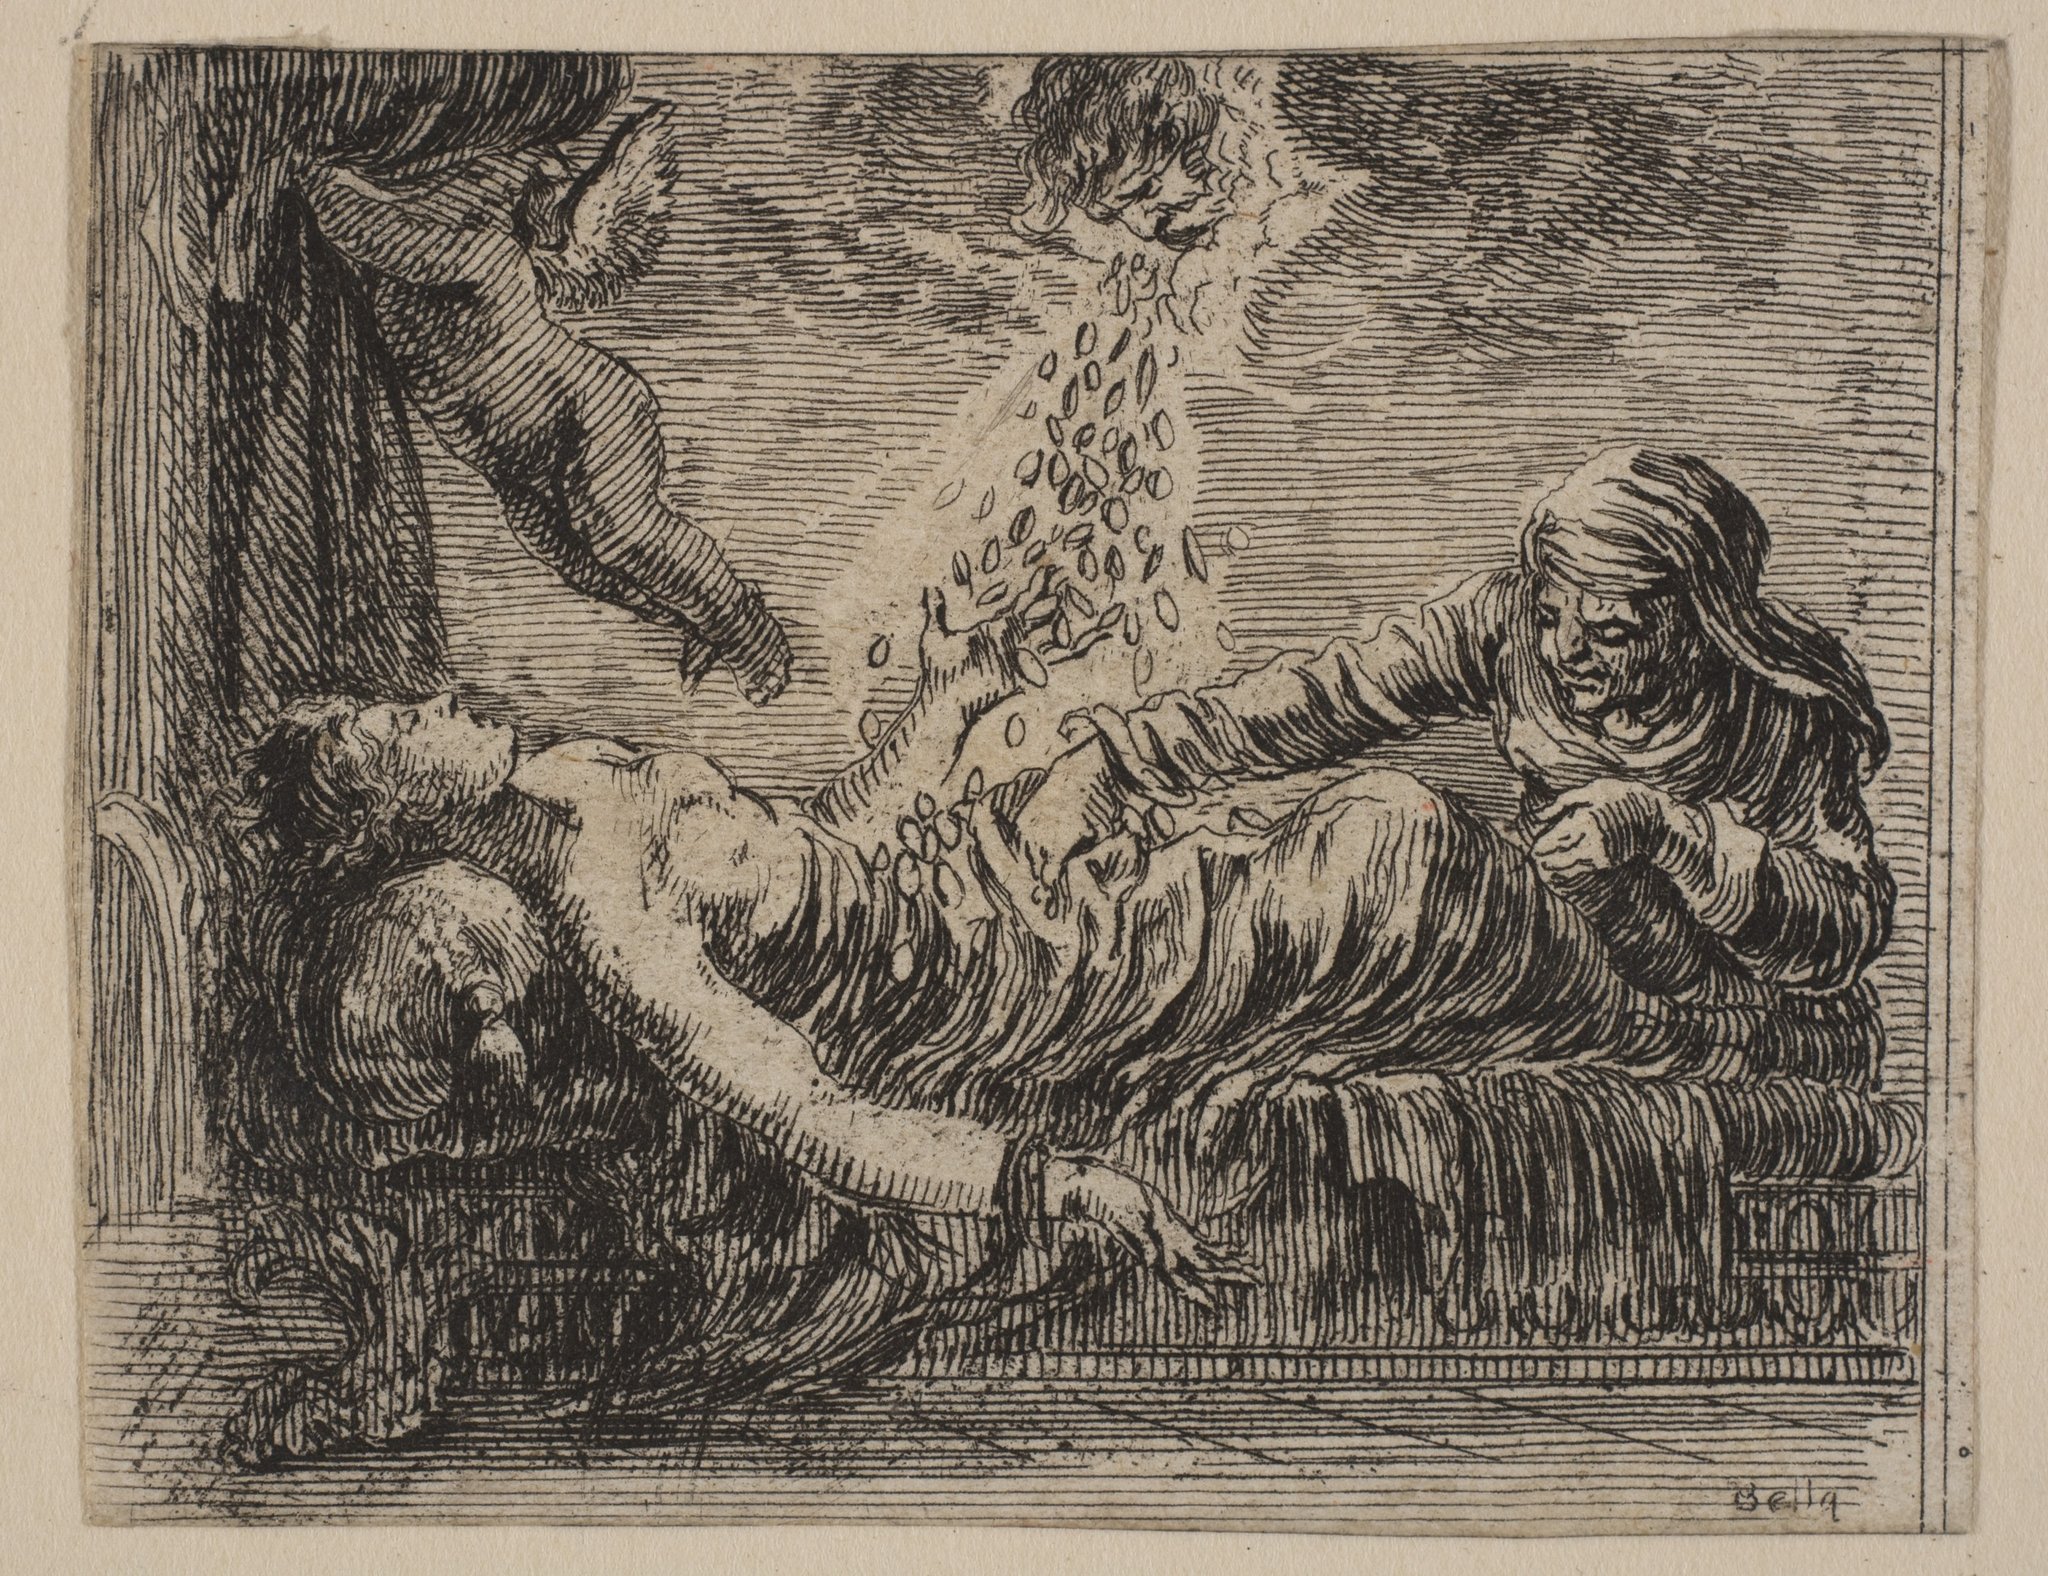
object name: print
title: Jupiter and Danäe, from 'Game of Mythology' (Jeu de la Mythologie)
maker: stefano della bella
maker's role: artist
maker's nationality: italian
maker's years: 1610-1664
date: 1644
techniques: etching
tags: women,jupiter